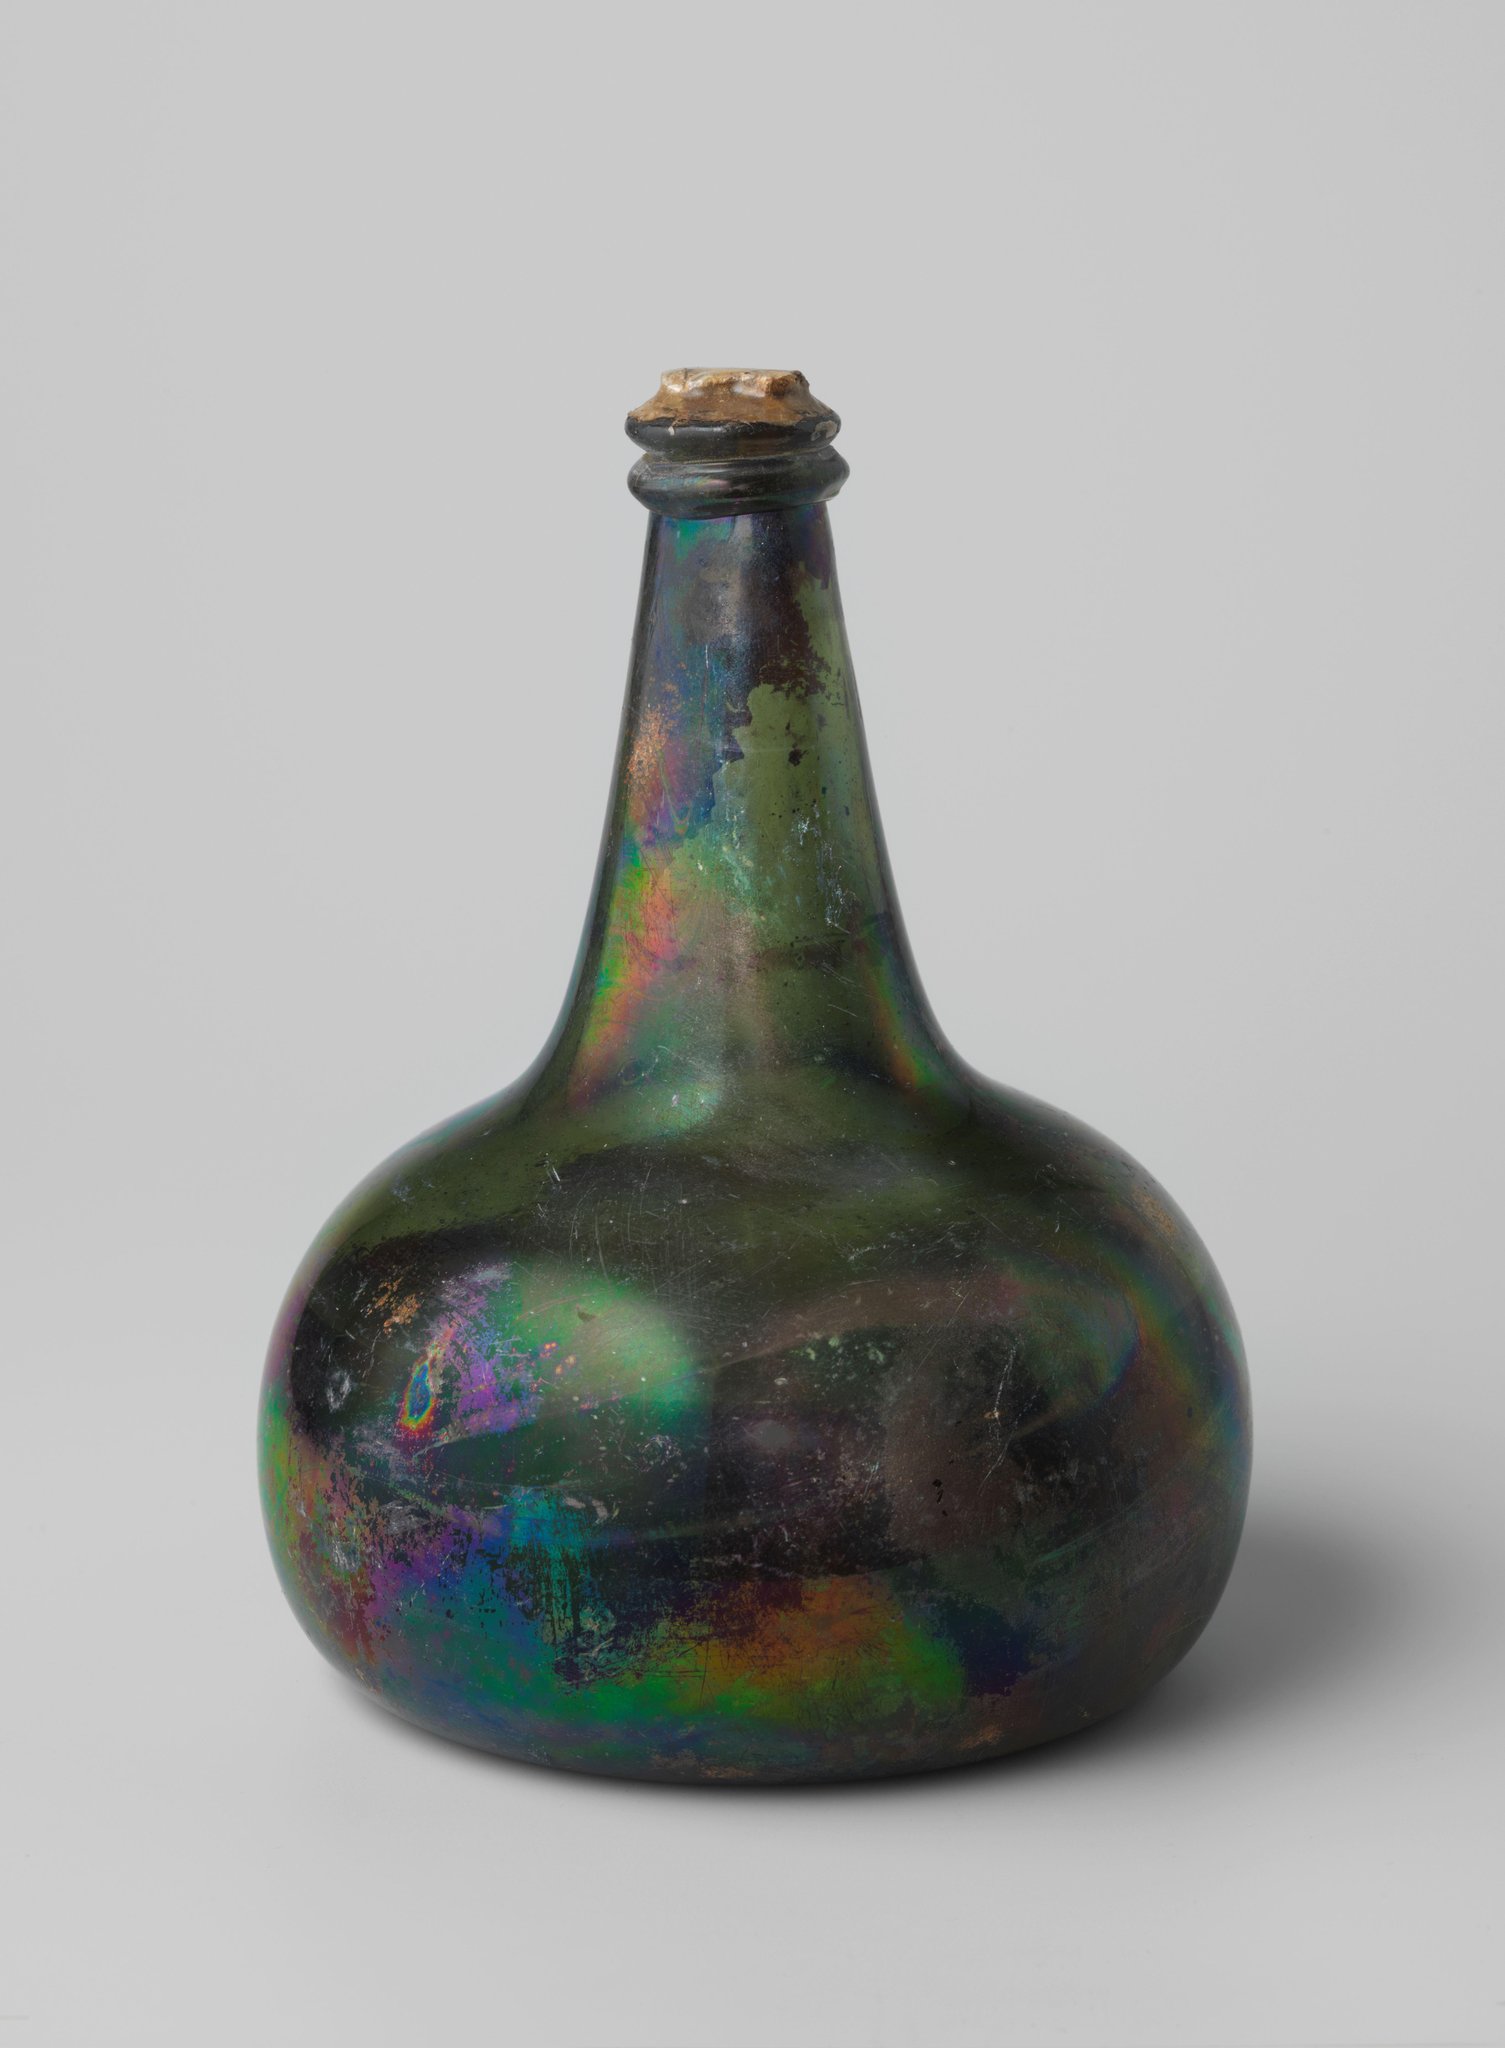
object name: wine bottle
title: Wijnfles met wijn uit het wrak van de Oost-Indiëvaarder 't Vliegend Hart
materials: glass, liquid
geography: netherlands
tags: 't vliegend hart (schip), verenigde oostindische compagnie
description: Uivormige wijnfles van groen glas gevuld met rode (port)wijn en afgesloten met kurk. De afsluitende draad is verdwenen.